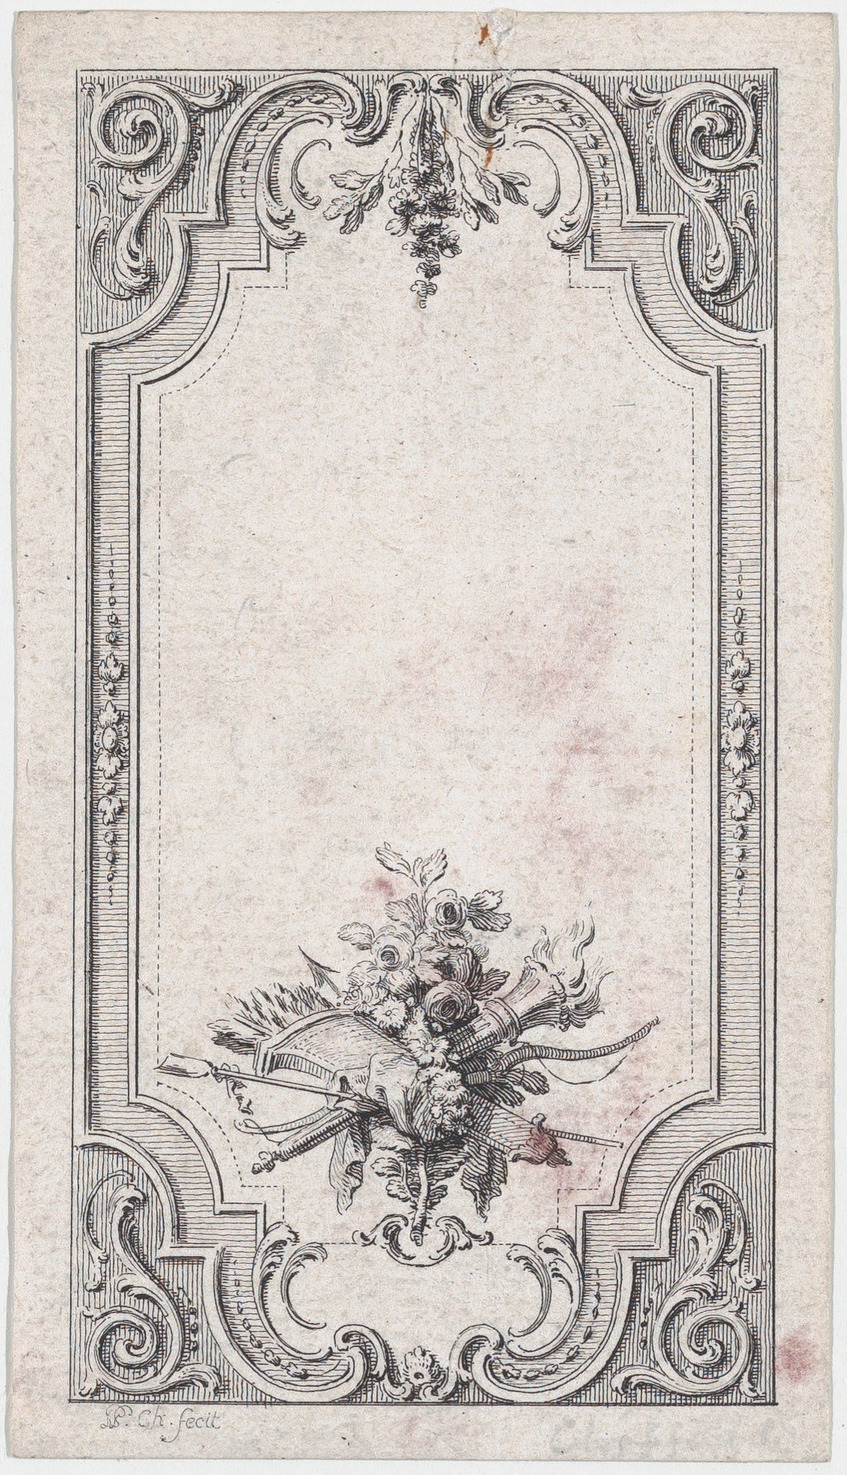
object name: print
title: Frontispiece, from Bussy-Rabutin's "Histoire amoureuse des Gaules"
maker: pierre philippe choffard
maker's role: artist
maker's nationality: french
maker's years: 1730-1809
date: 1754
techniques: engraving, etching